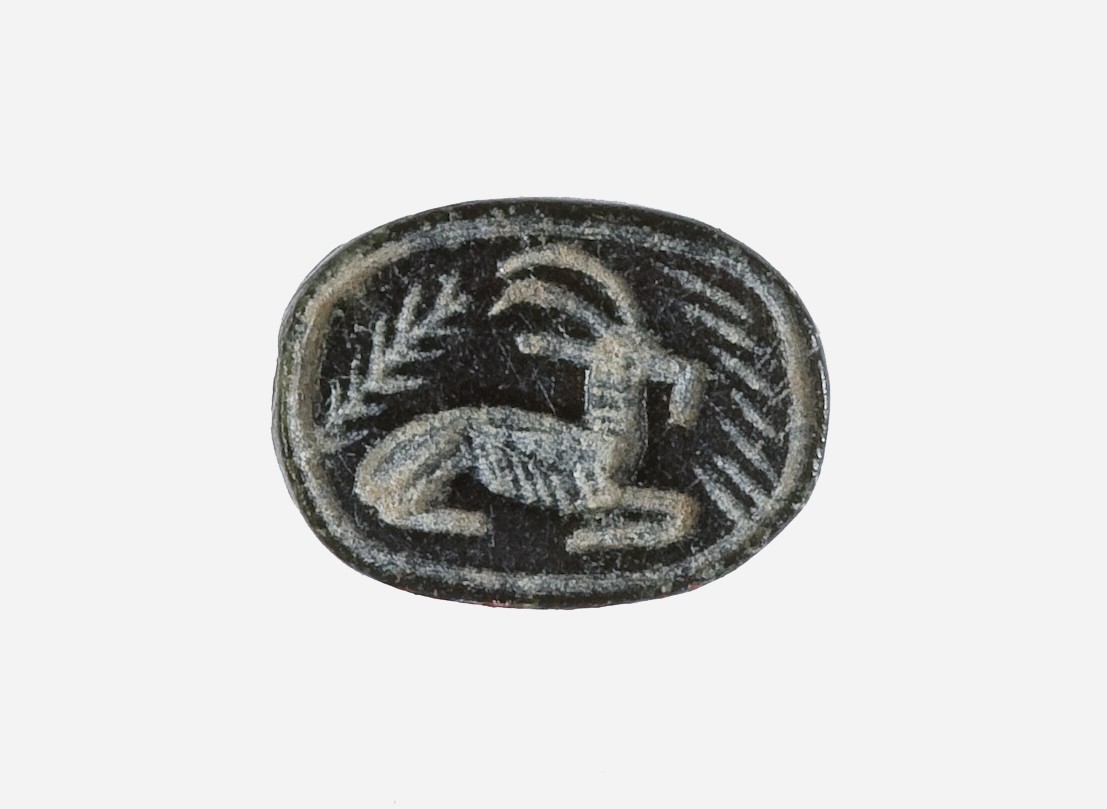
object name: scarab, ibex, frond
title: Scarab Inscribed with a Crouching Ibex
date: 1390-1352 BCE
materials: stone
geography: egypt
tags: ibex